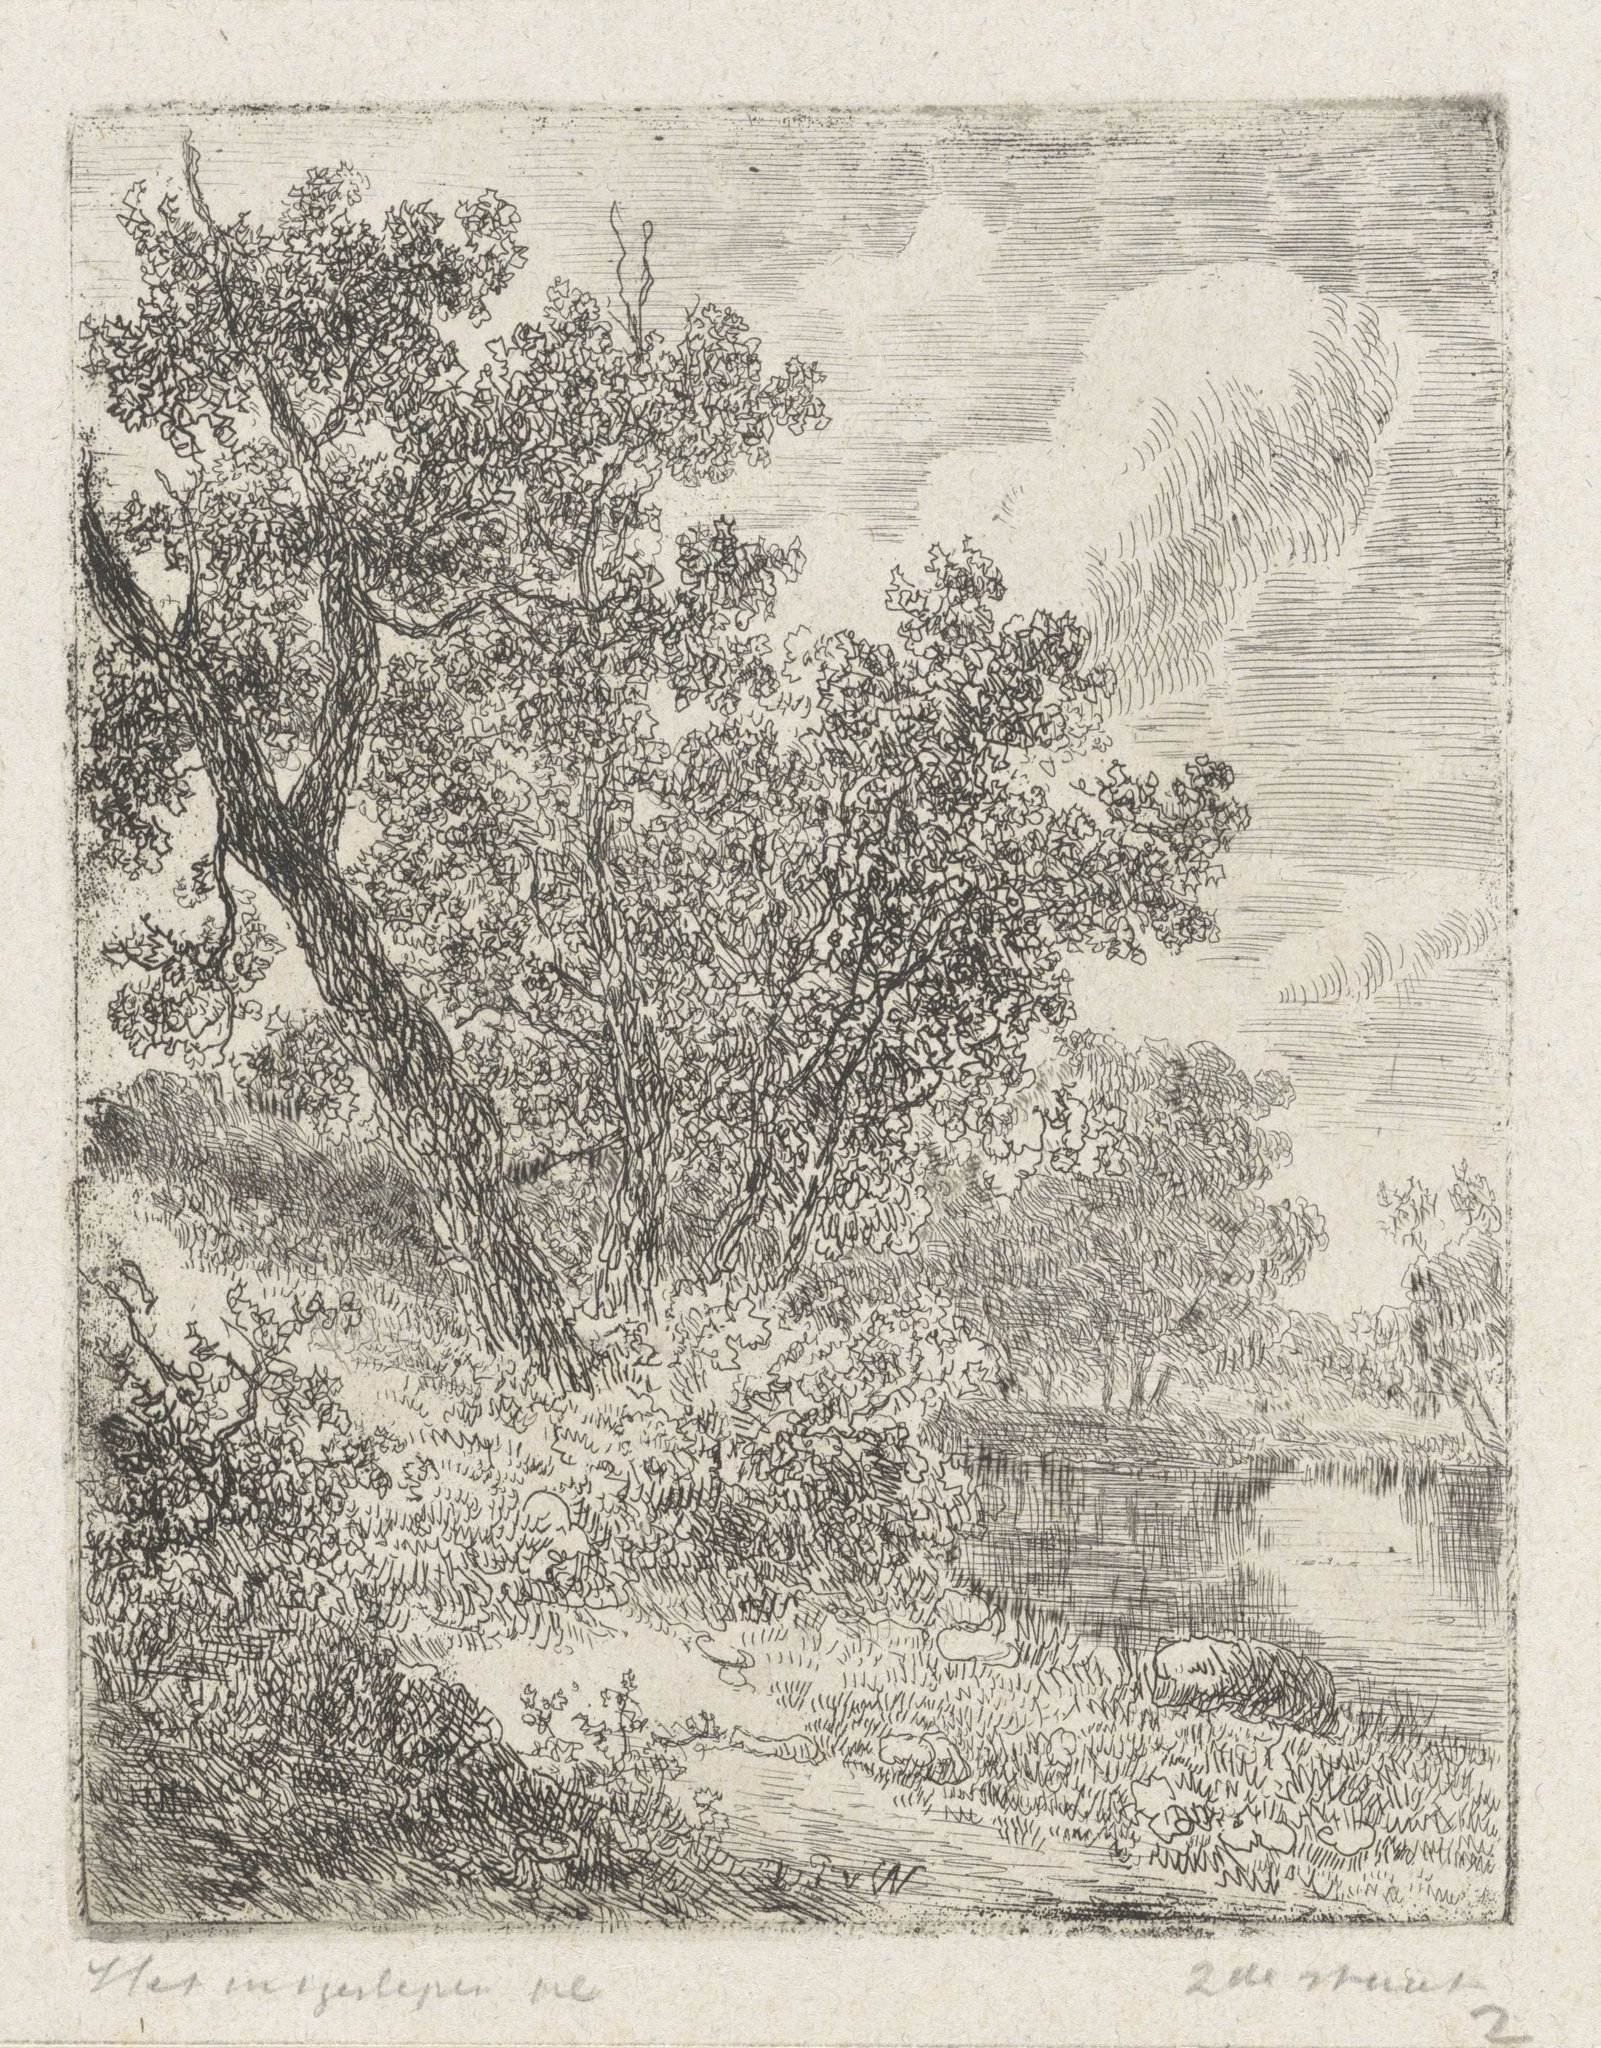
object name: print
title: Rivieroever met bomen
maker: Anonymous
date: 1830-1882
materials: paper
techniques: etching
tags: trees, river bank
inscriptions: collector's mark: Lugt 2228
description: Ongesigneerde kopie in spiegelbeeld naar RP-P-OB-24.497.